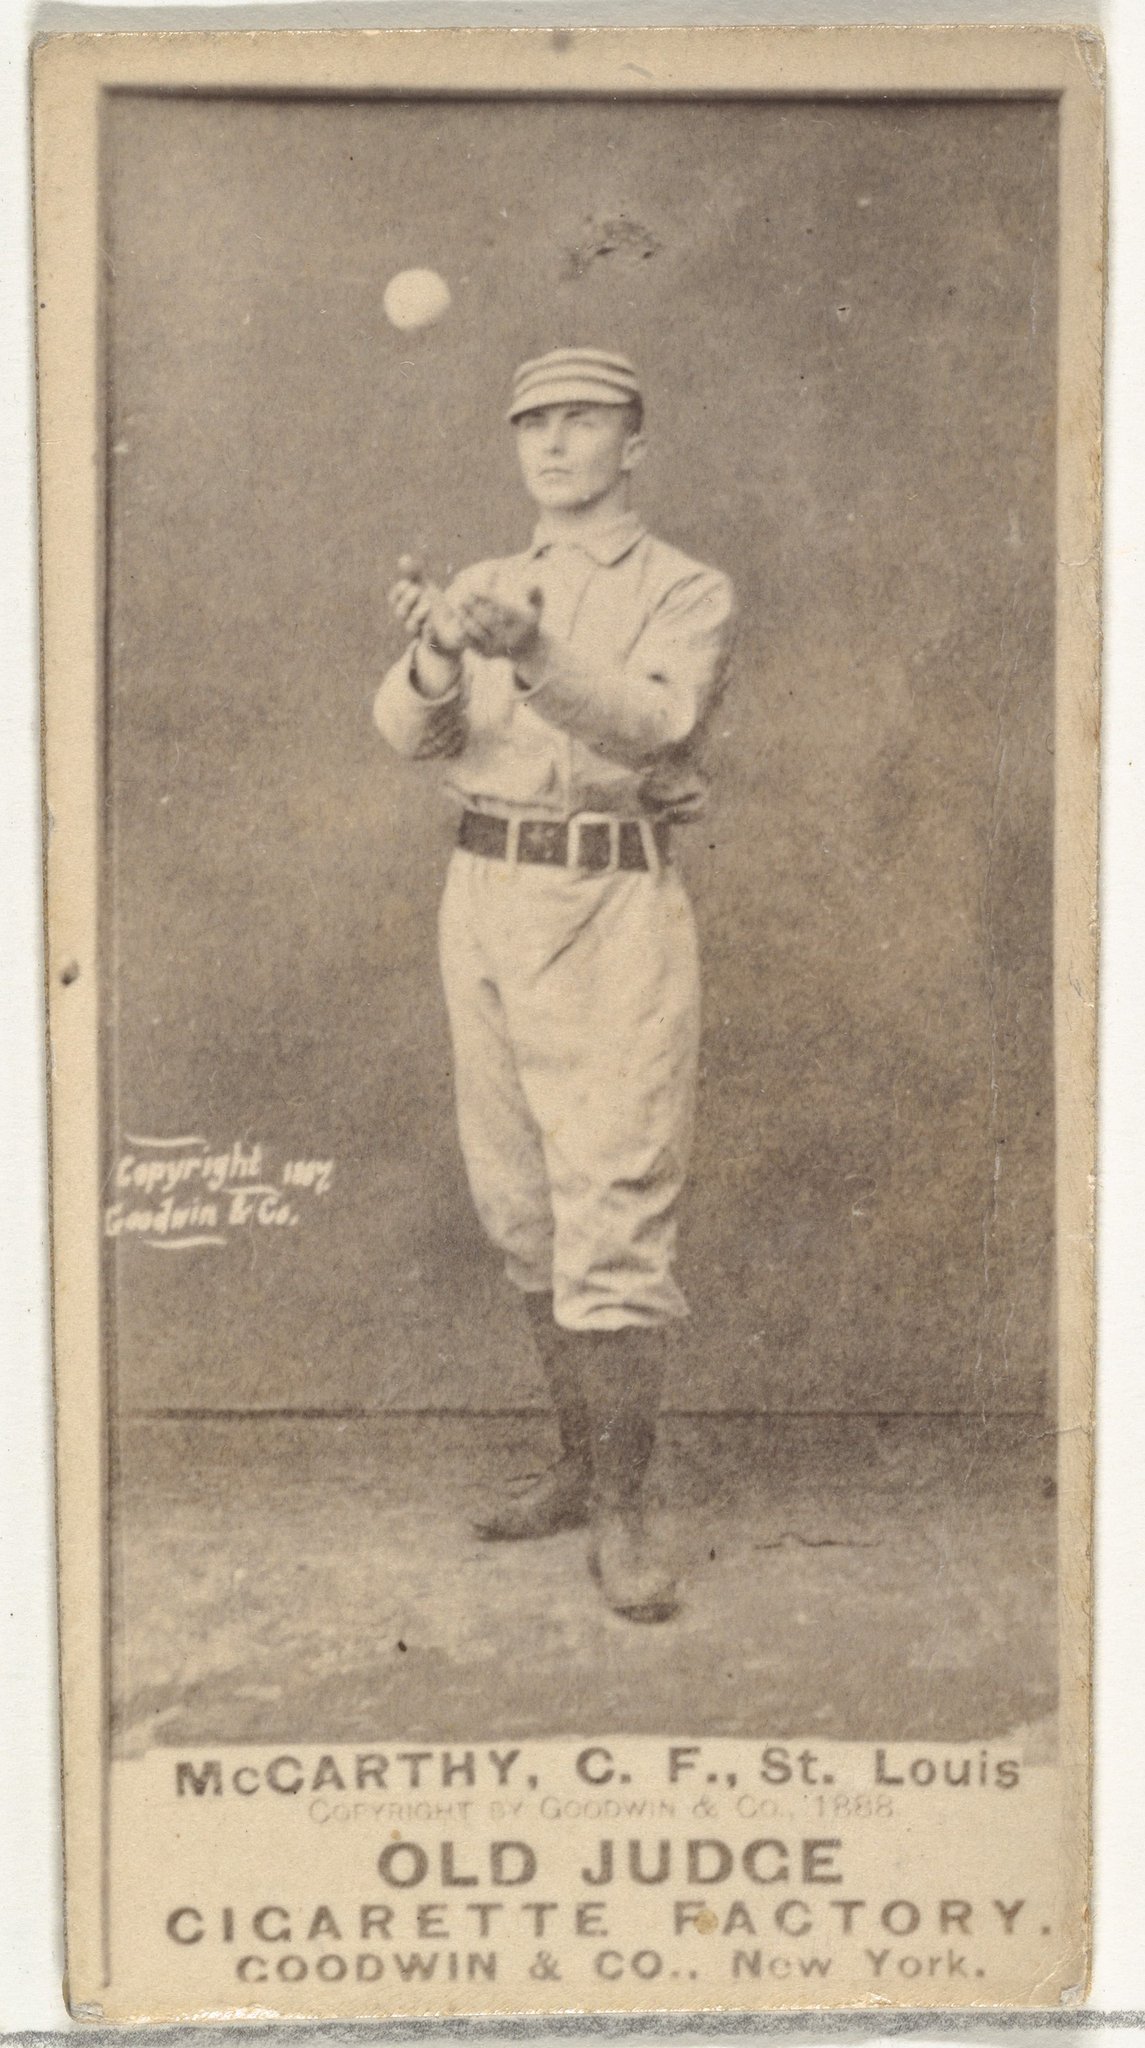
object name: baseball card, photograph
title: Tommy McCarthy, Center Field, St. Louis Browns, from the Old Judge series (N172) for Old Judge Cigarettes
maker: goodwin & company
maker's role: publisher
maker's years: 1850-1950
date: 1888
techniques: albumen silver print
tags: men,portraits,baseball,athletes